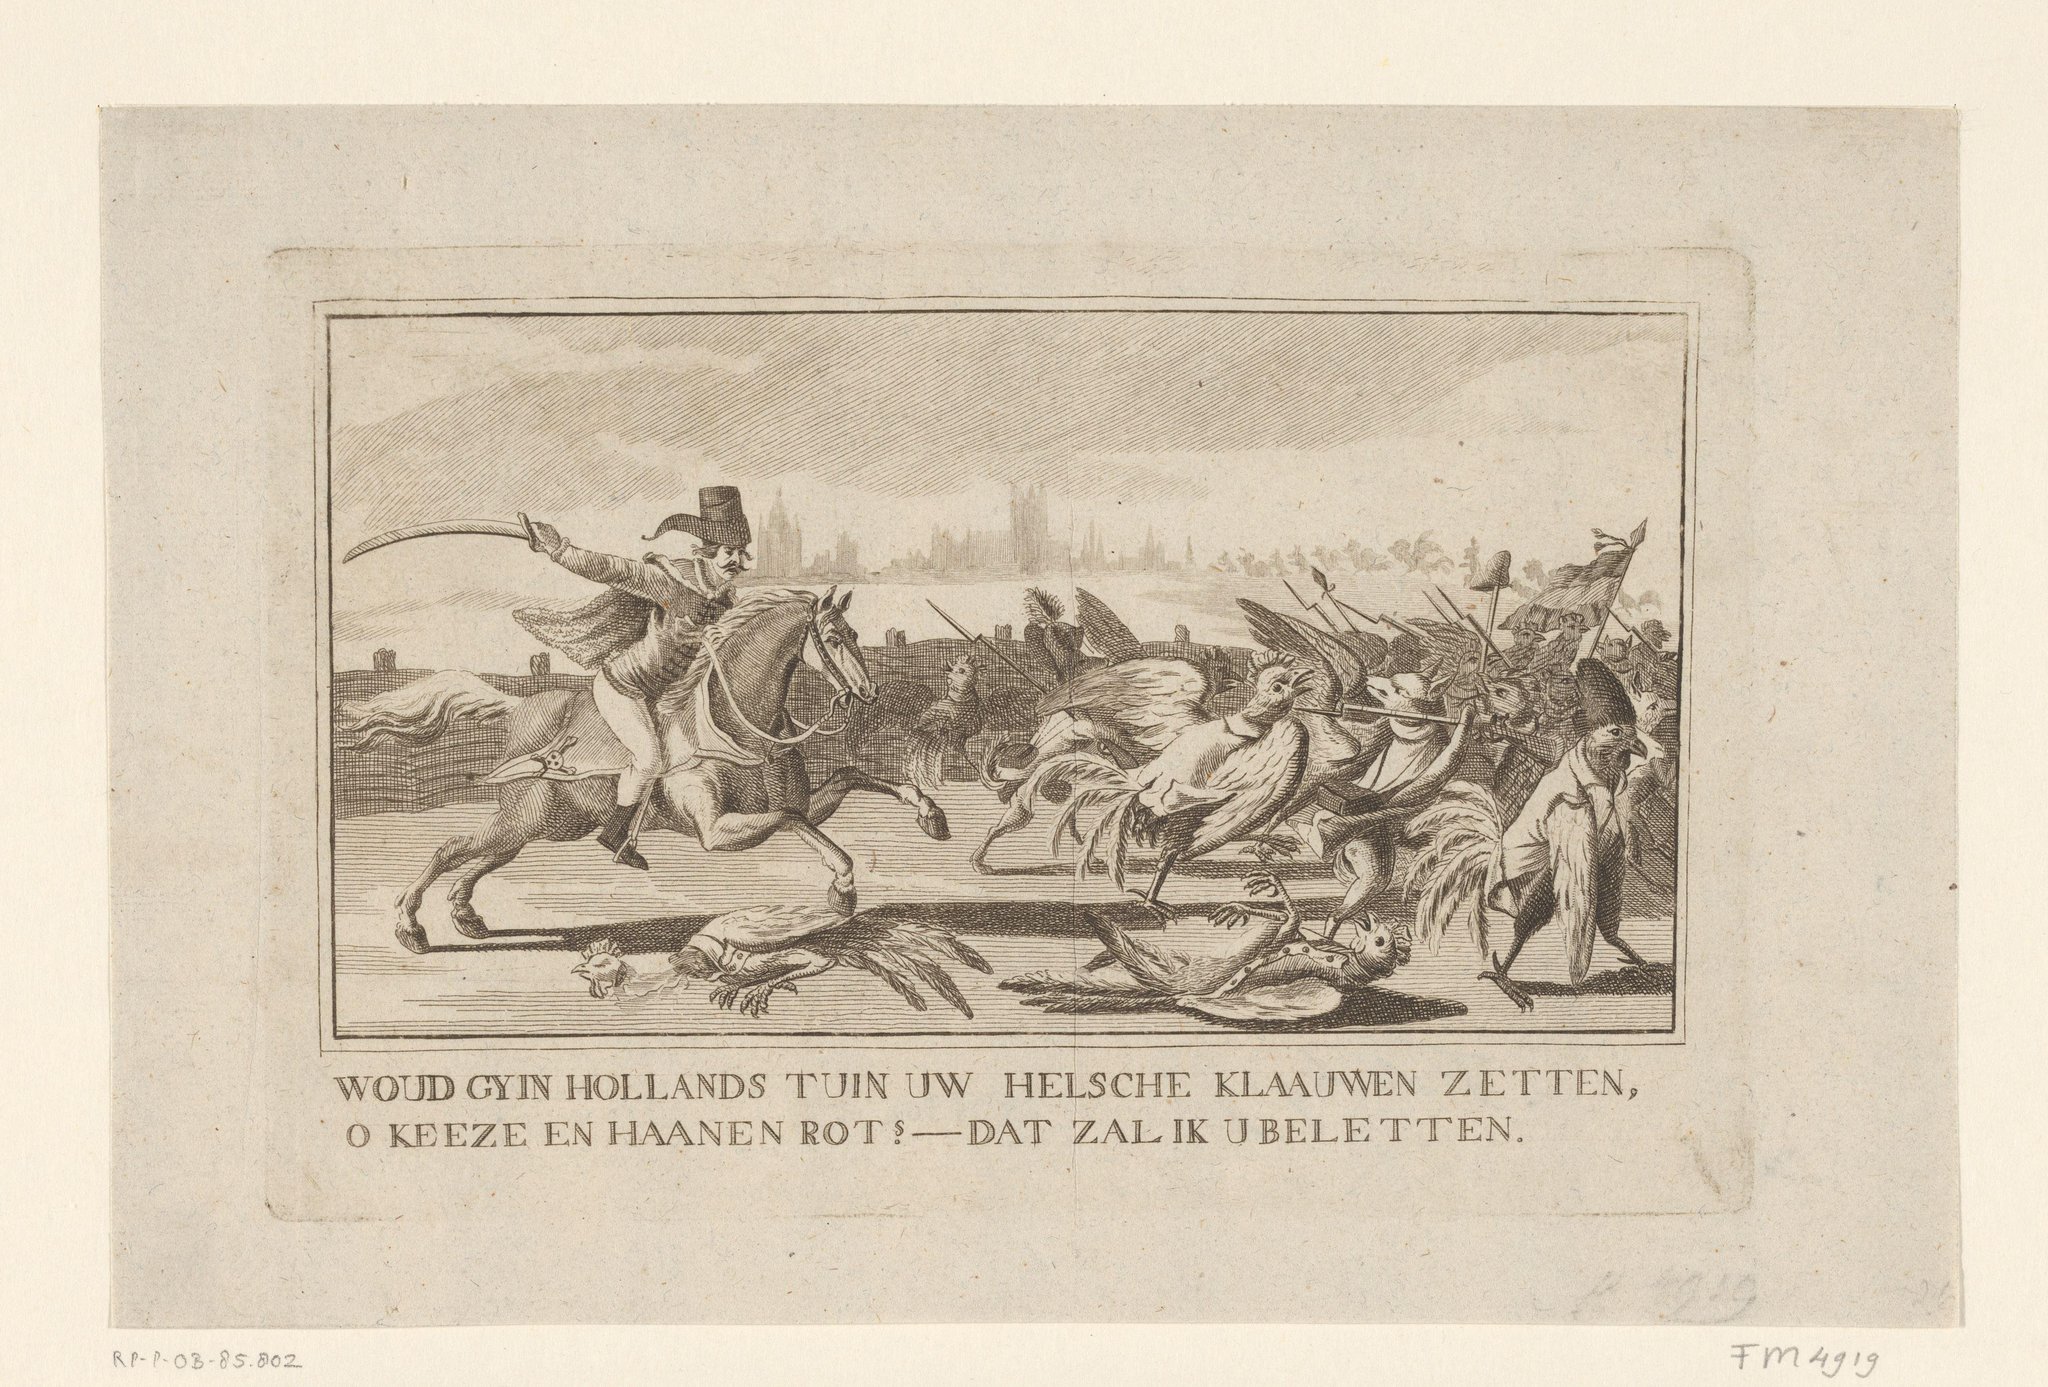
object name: cartoon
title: De Pruisische ruiter verjaagt de kezen en de hanen, 1787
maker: Anonymous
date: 1787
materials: paper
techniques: engraving, etching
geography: northern netherlands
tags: pruisische inval in de republiek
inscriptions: collector's mark: Lugt 2228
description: Allegorische voorstelling van de Pruisische interventie in de Nederlanden, 1787. Een Pruisische ruiter van het regiment Totenkopfhusaren verjaagt met getrokken sabel de Franse hanen en keeshonden (patriotten) uit de Hollandse Tuin.